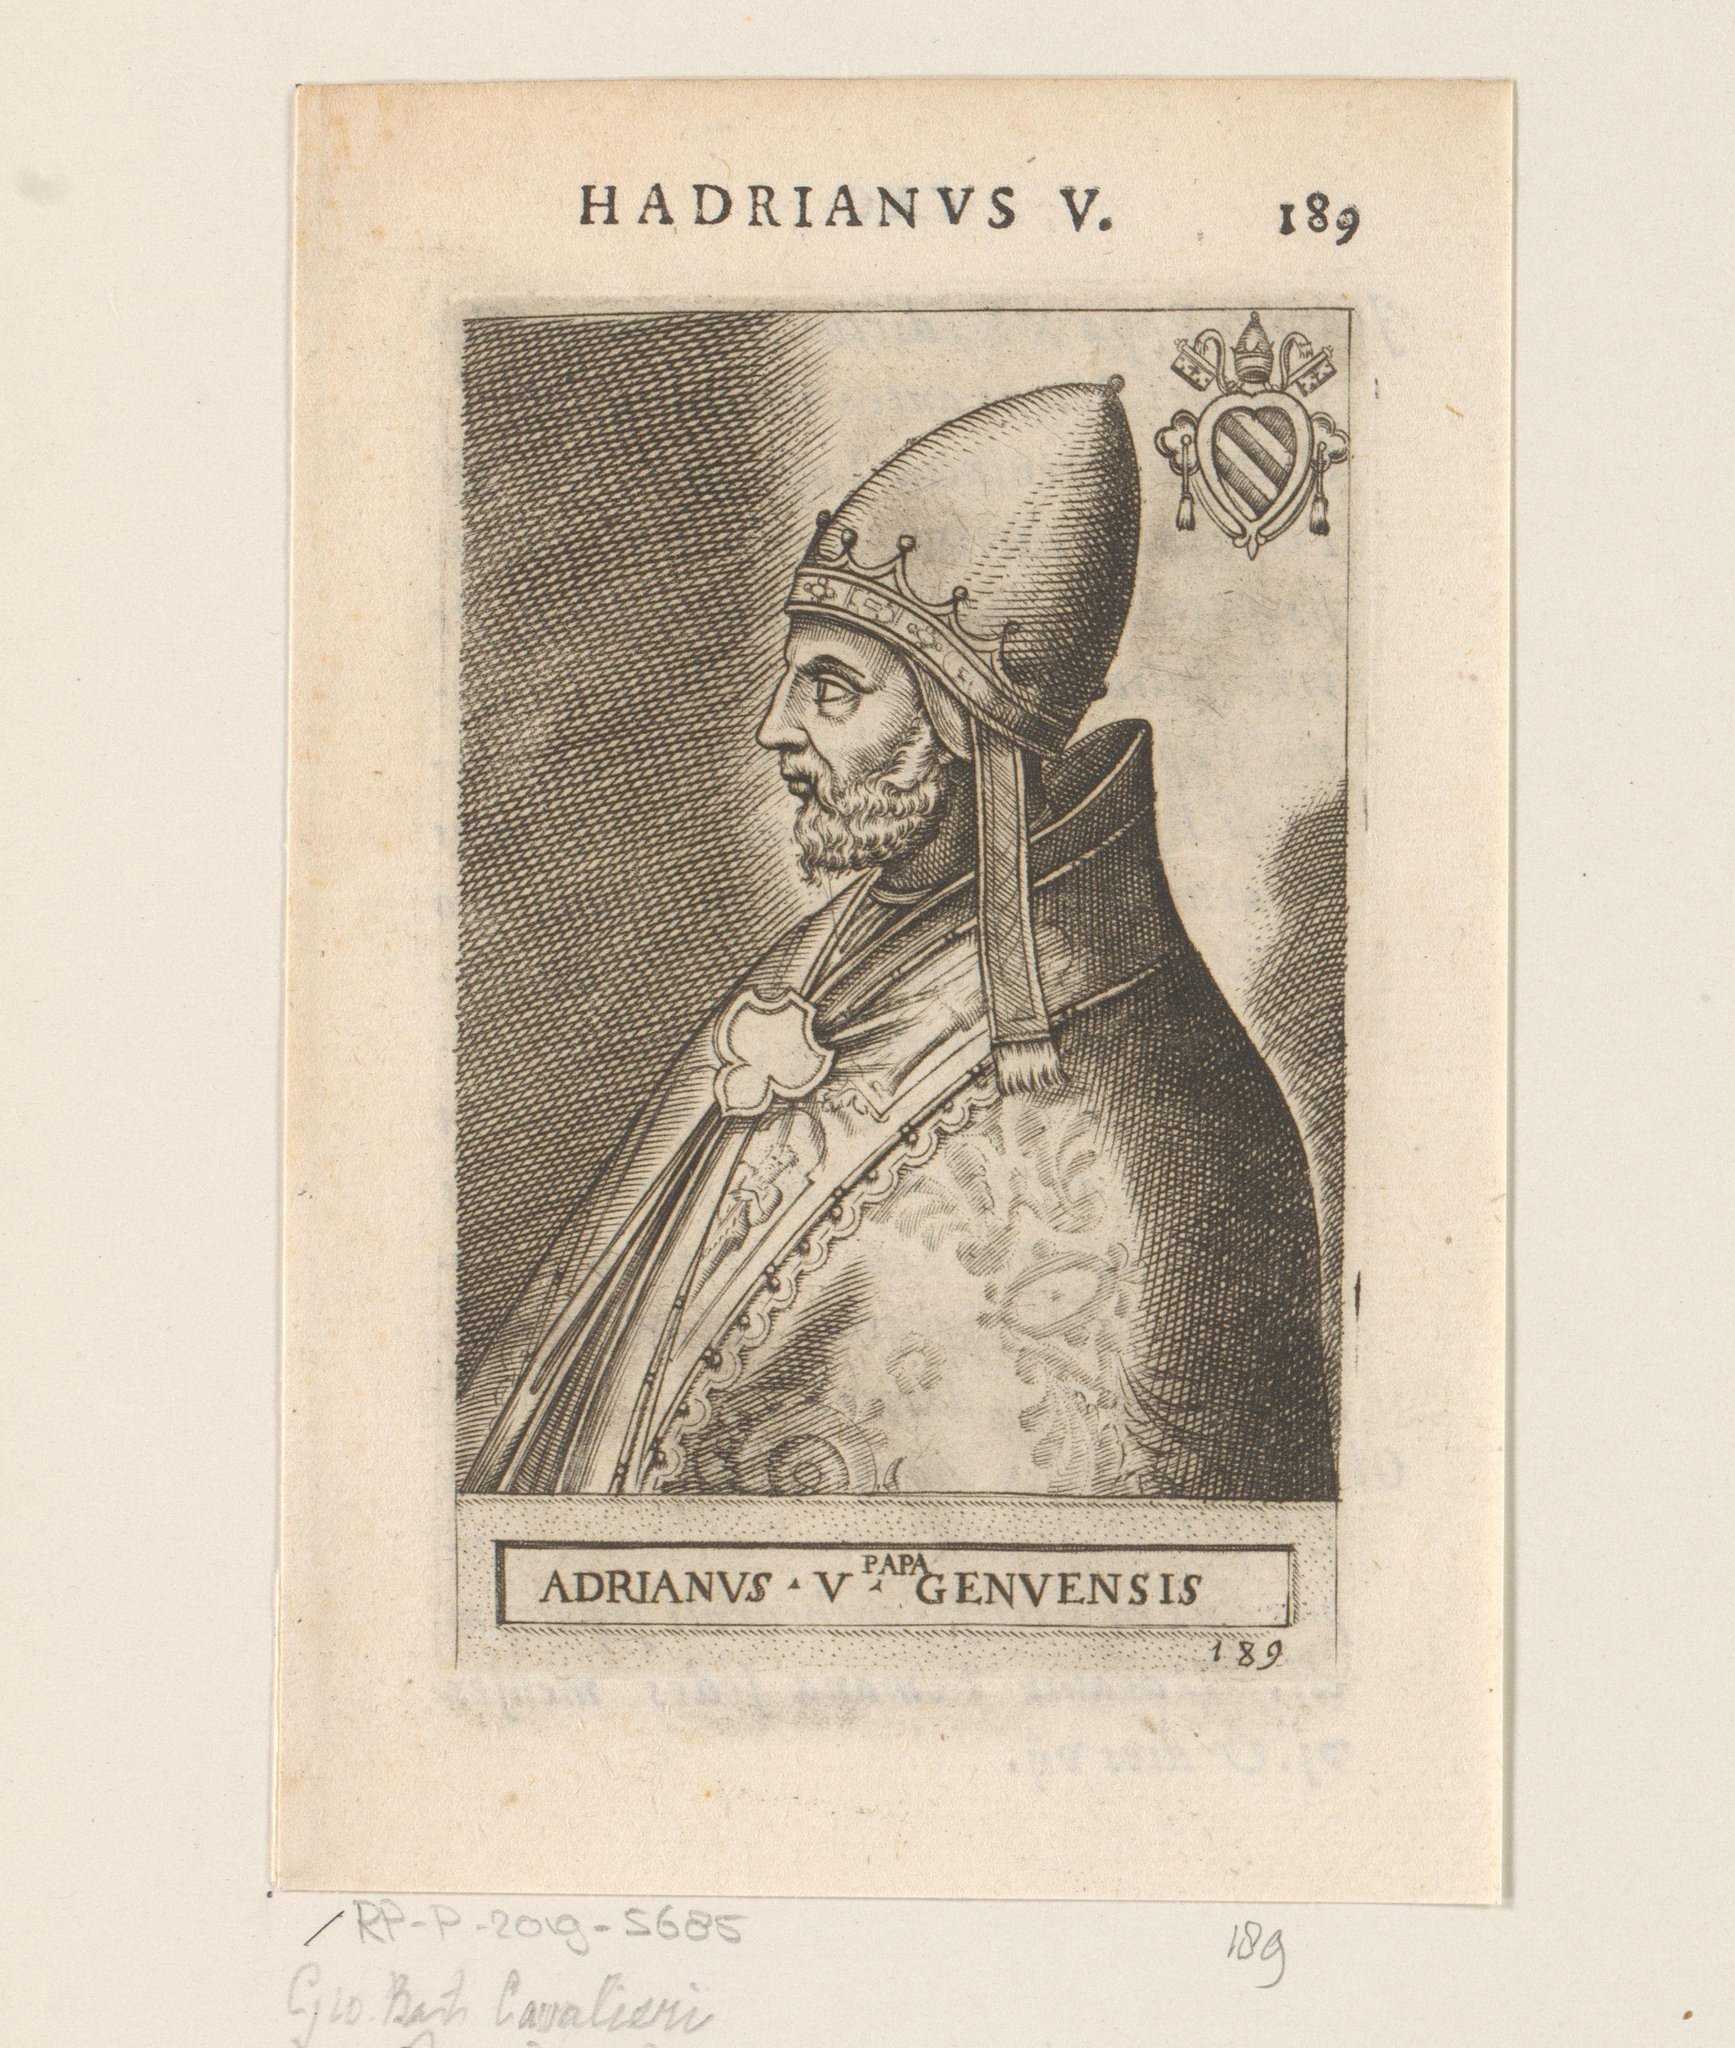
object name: print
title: Adrianus V Papa Genvensis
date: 1595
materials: paper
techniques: engraving, letterpress printing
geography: rome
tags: historical persons, pope, armorial bearing, heraldry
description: Prent uit: Cavalieri, Giovanni Battista de'. Effigies pontificum romanorum cum eorum vitis (...). Rome: Bartolomeo Bonfadino, 1595. Prent voor het eerst verschenen in: Cavalieri, Giovanni Battista de'. Pontificum romanorum effigies (...). Rome: Domenico Basa en Francesco Zanetti, 1580. Prent ook gebruikt in latere publicaties.